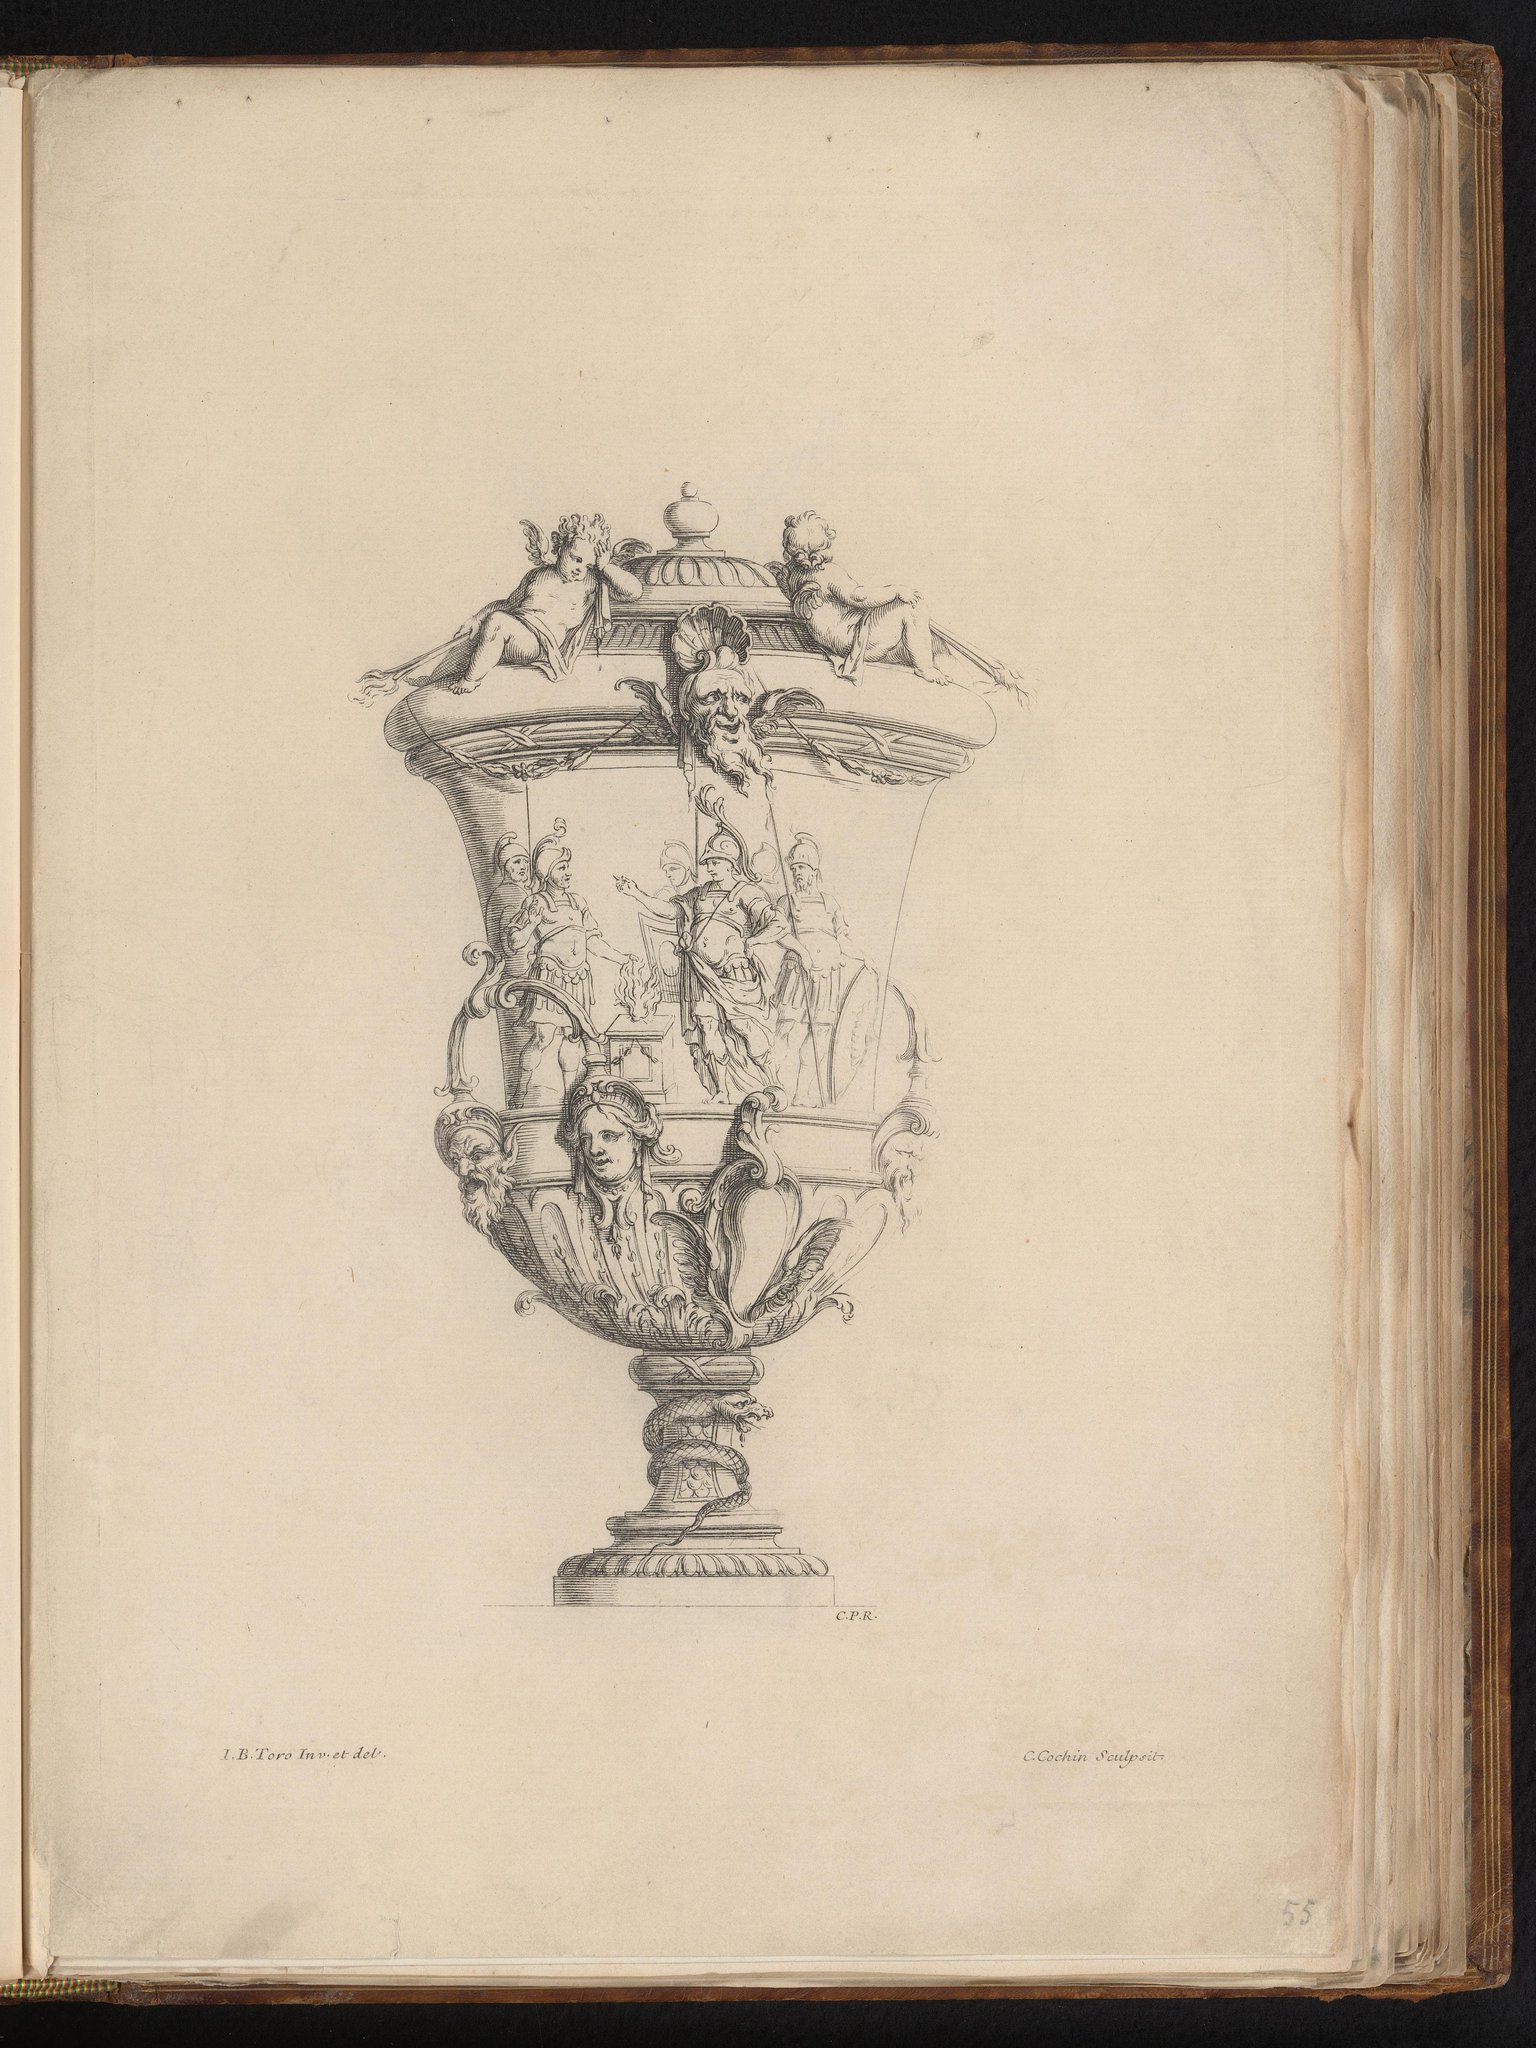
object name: print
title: Nouveau Livre de Vases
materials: paper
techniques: etching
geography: paris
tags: vase ~ ornament, the soldier; the soldier's life, garden vase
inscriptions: collector's mark: Lugt 2760, collector's mark: Lugt 2228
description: Prent maakt deel uit van een serie van zeven prenten.